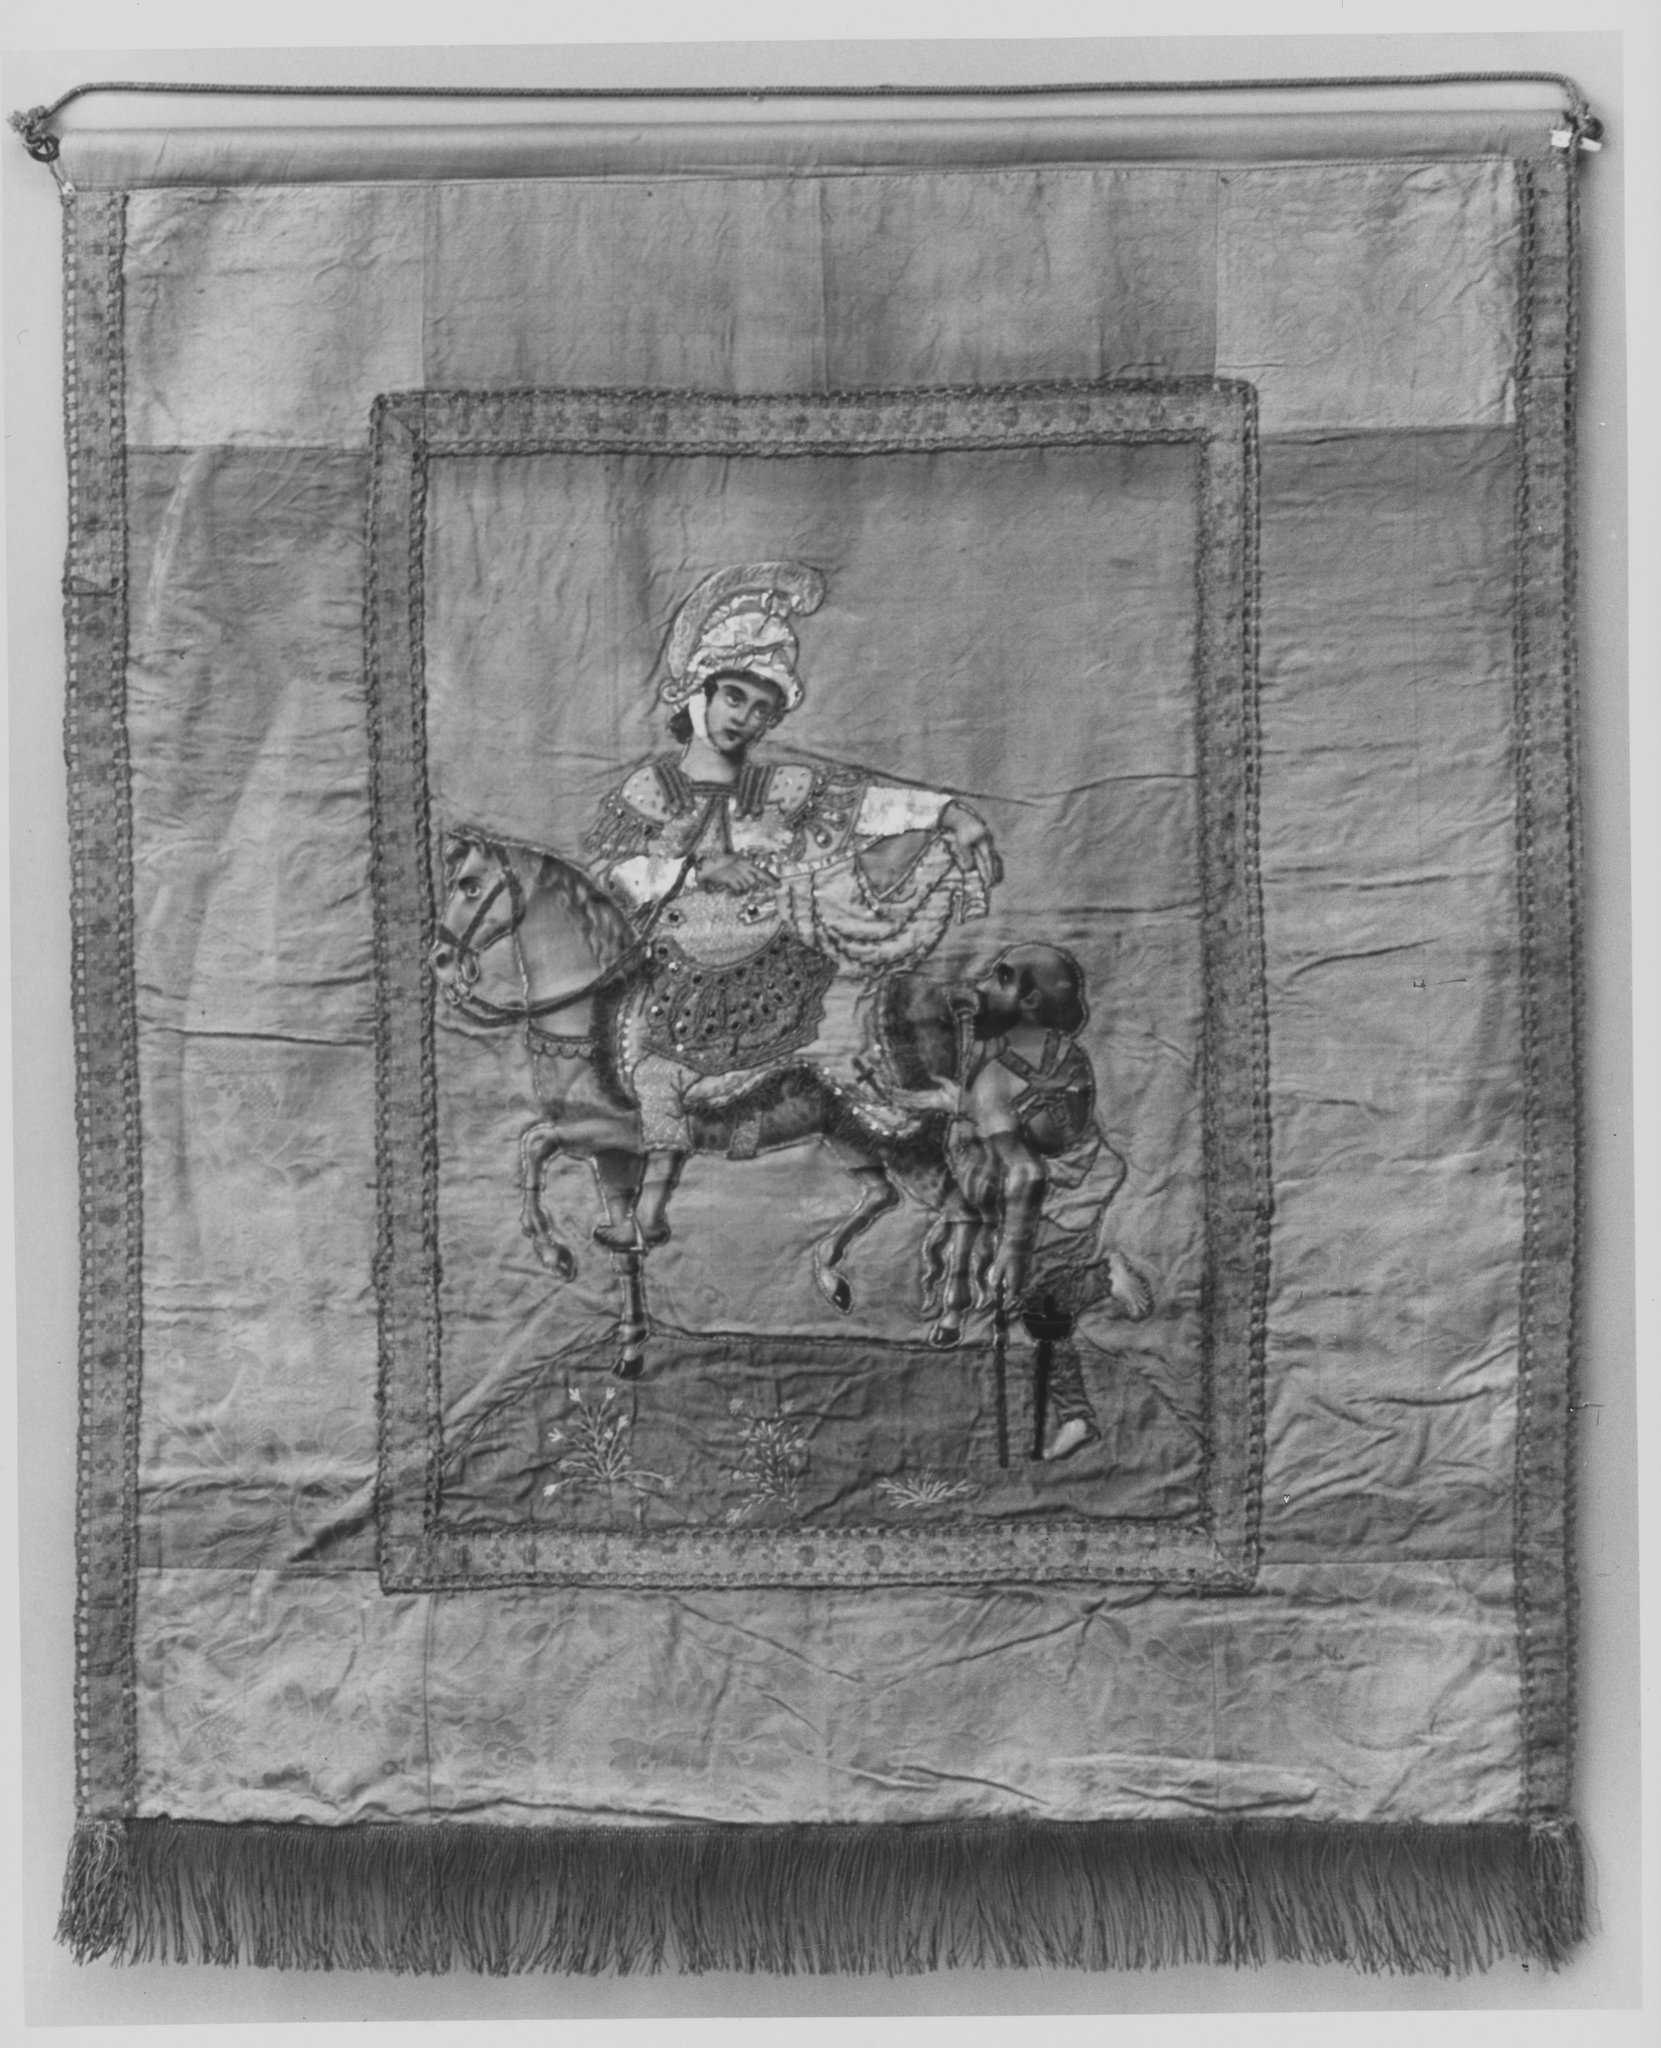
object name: church banner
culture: russian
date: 1810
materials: gilt, textile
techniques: polychromy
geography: russia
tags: men,horses